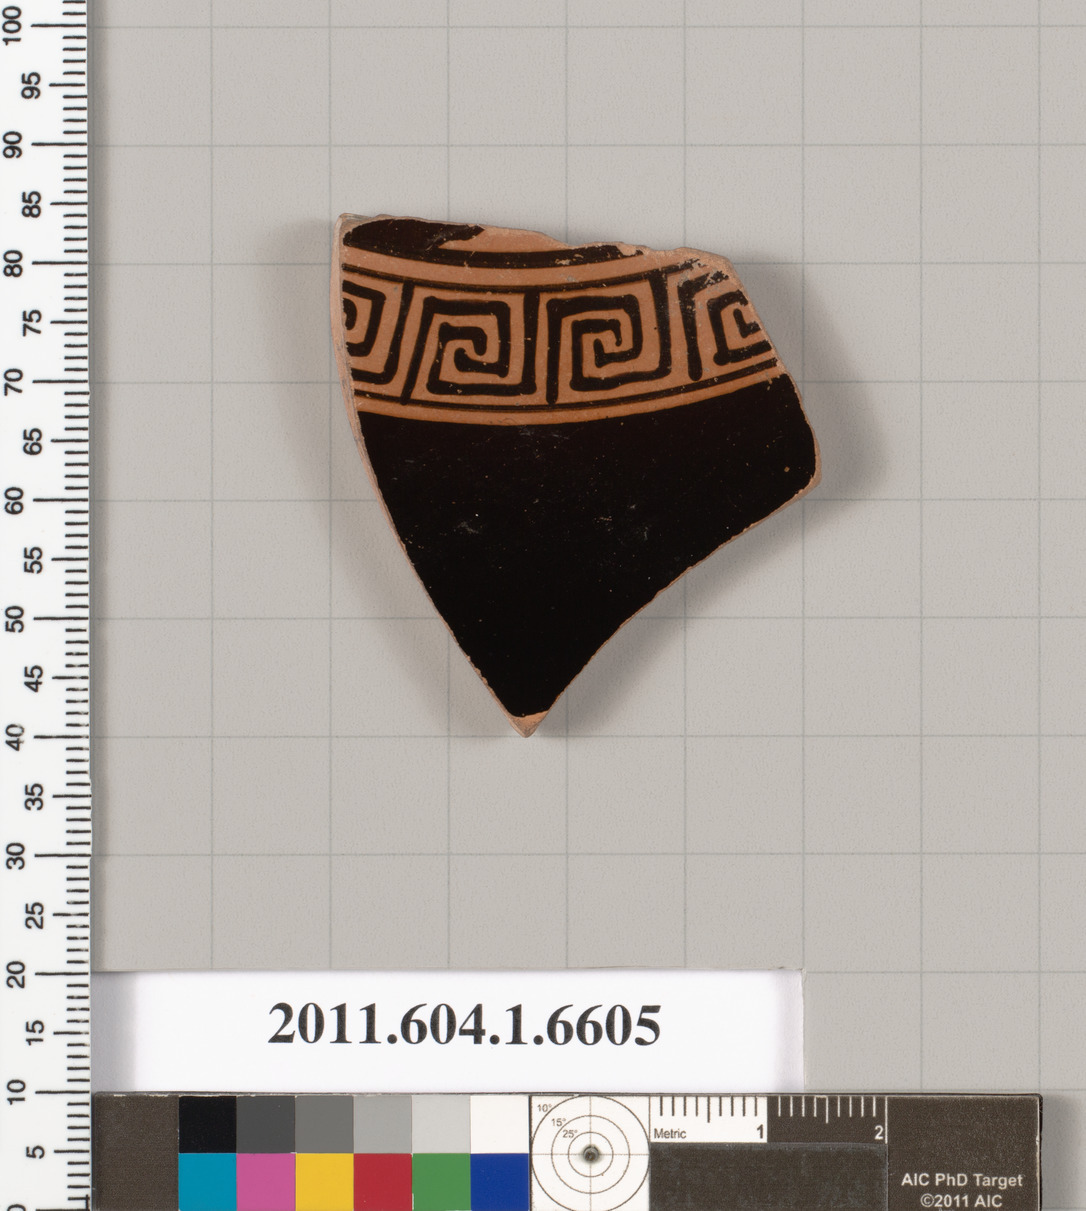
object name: kylix fragment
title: Terracotta fragment of a kylix (drinking cup)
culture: greek, attic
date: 490-480 BCE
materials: terracotta